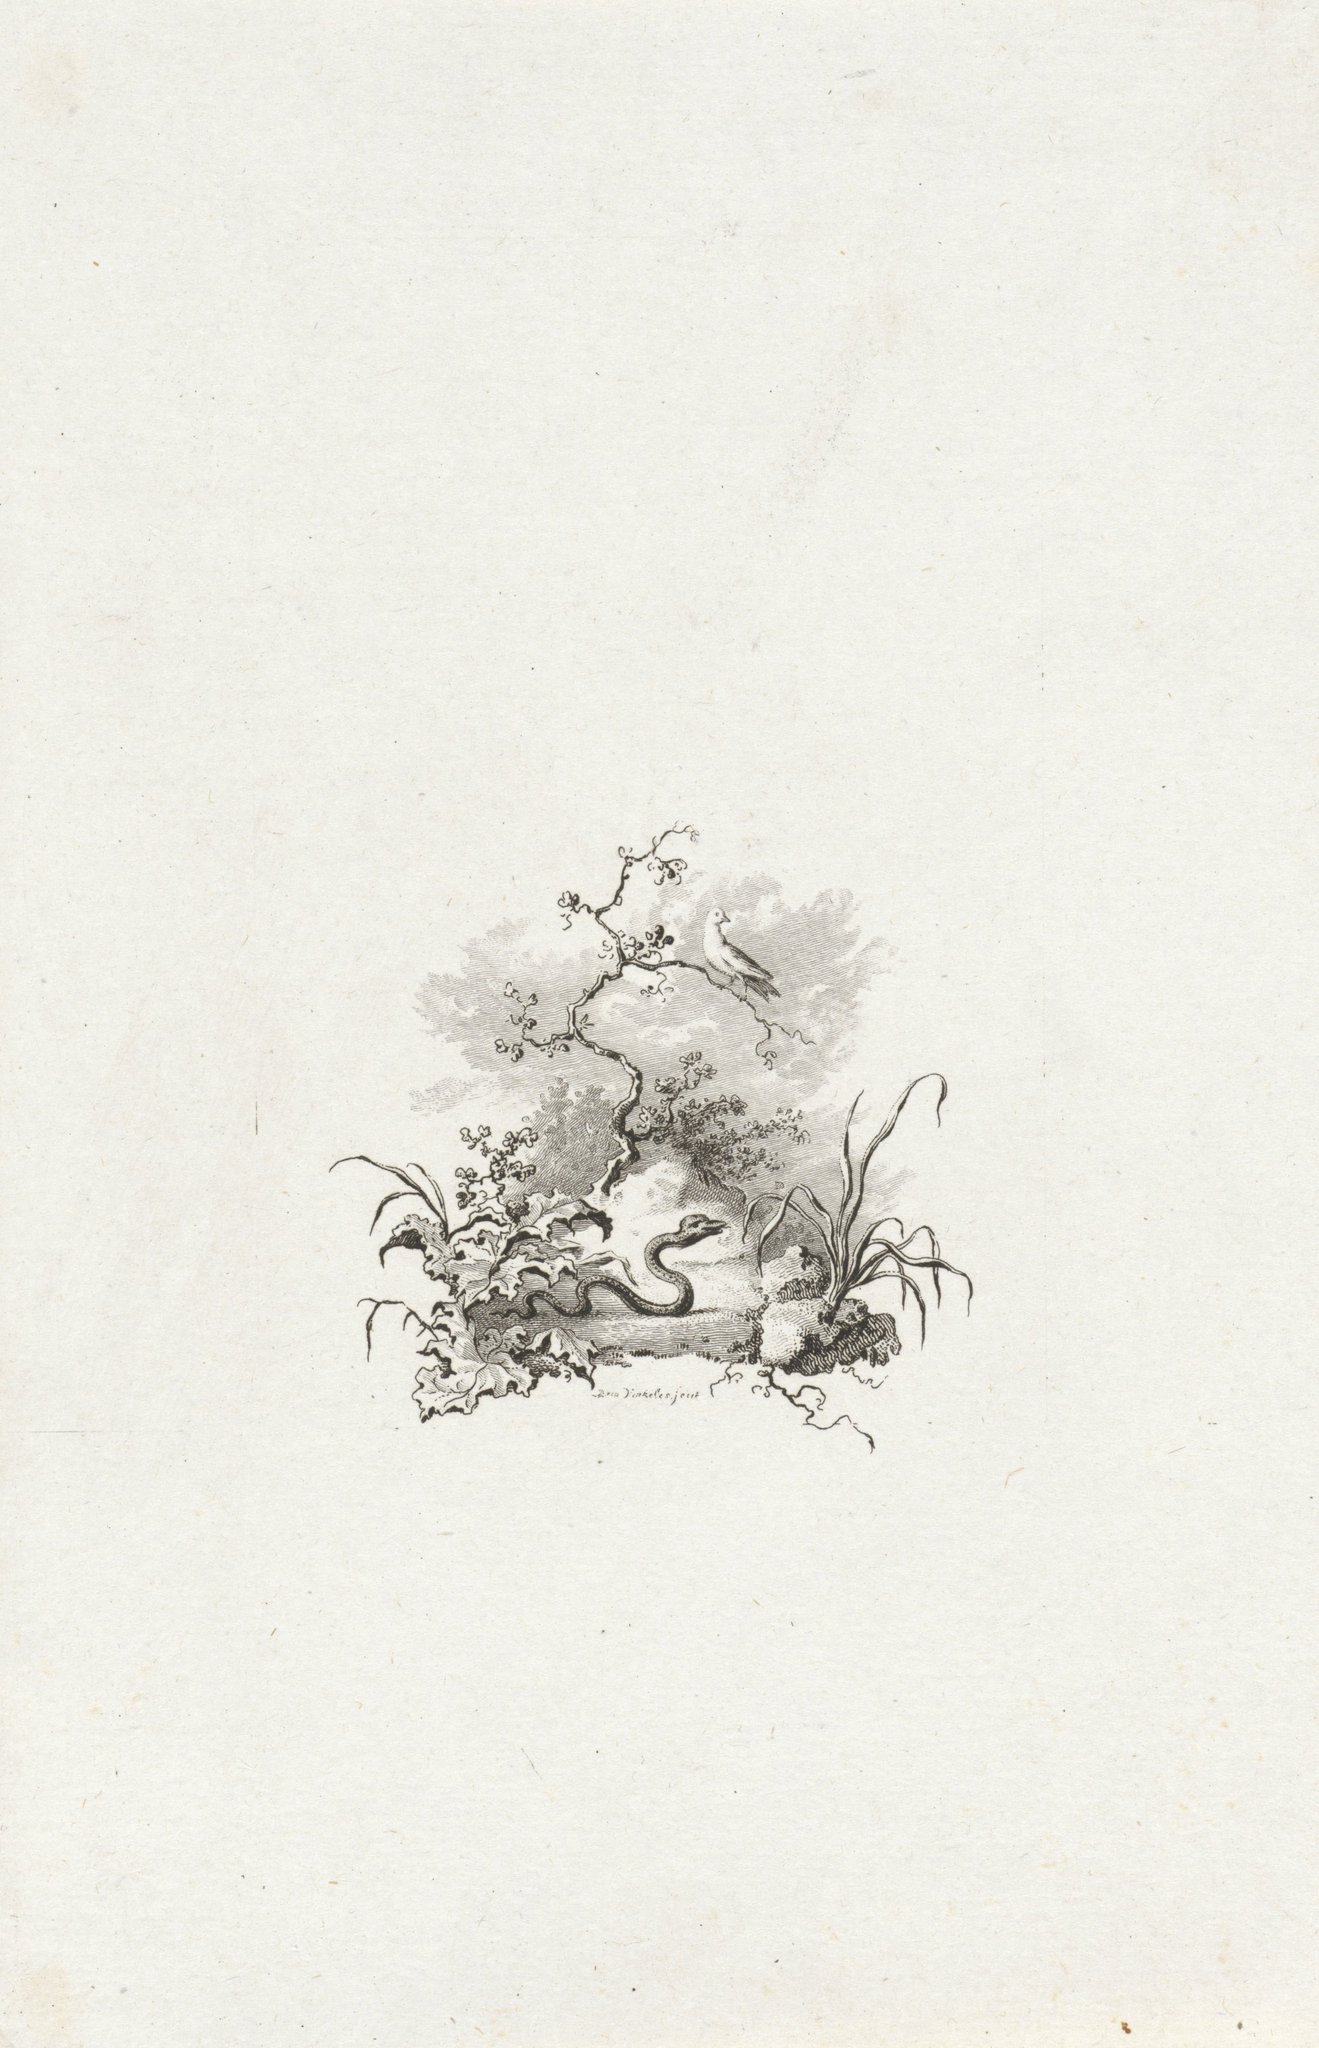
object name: print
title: Slang en duif in de woestijn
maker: reinier vinkeles (i)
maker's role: draughtsman, print maker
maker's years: 1741-1816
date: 1786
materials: paper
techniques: etching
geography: amsterdam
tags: snakes, other birds: dove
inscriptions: collector's mark: Lugt 240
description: Proefdruk van titelpagina voor: Herwerden, Henricus van. 's heilands verzoekingen in de woestijne. Amsterdam: Johannes Allart, 1786.